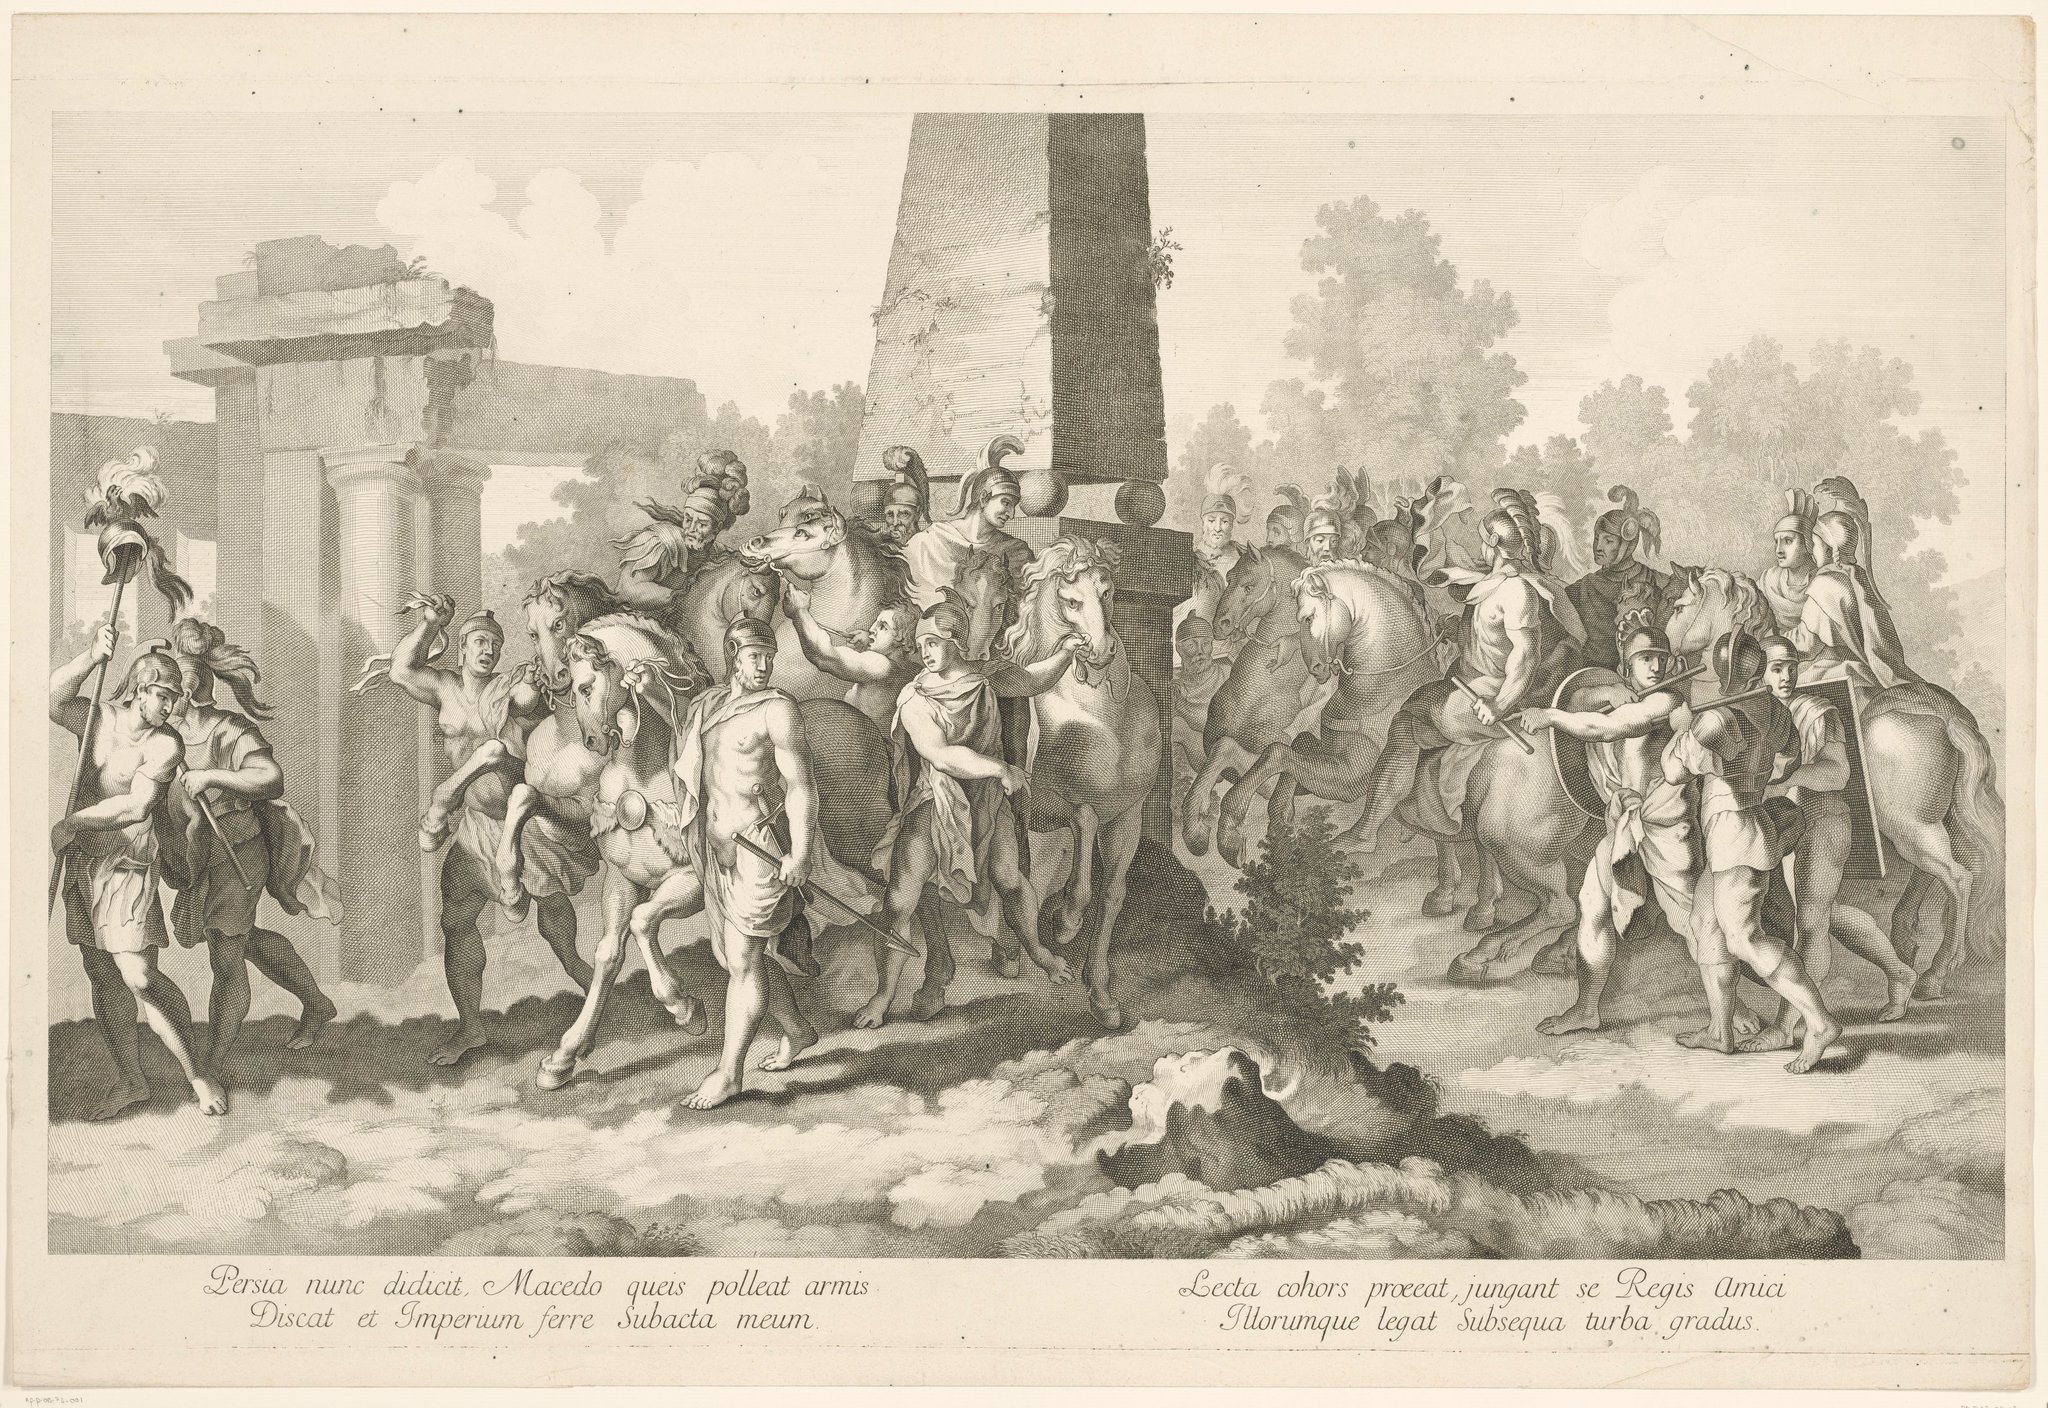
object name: print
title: Soldaten bij obelisk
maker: domenico rossetti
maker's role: print maker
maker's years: 1650-1736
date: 1660-1736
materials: paper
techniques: engraving, etching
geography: mannheim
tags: obelisk, needle, landscape with ruins, warfare; military affairs (+ cavalry, horsemen), the soldier; the soldier's life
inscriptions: collector's mark: Lugt 2228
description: Deze prent maakt deel uit van een reeks van twaalf prenten door verschillende prentmakers naar de grisailles door Gerard de Lairesse in Schloss Mannheim van de Triomftocht van Alexander de Grote in Babylon.